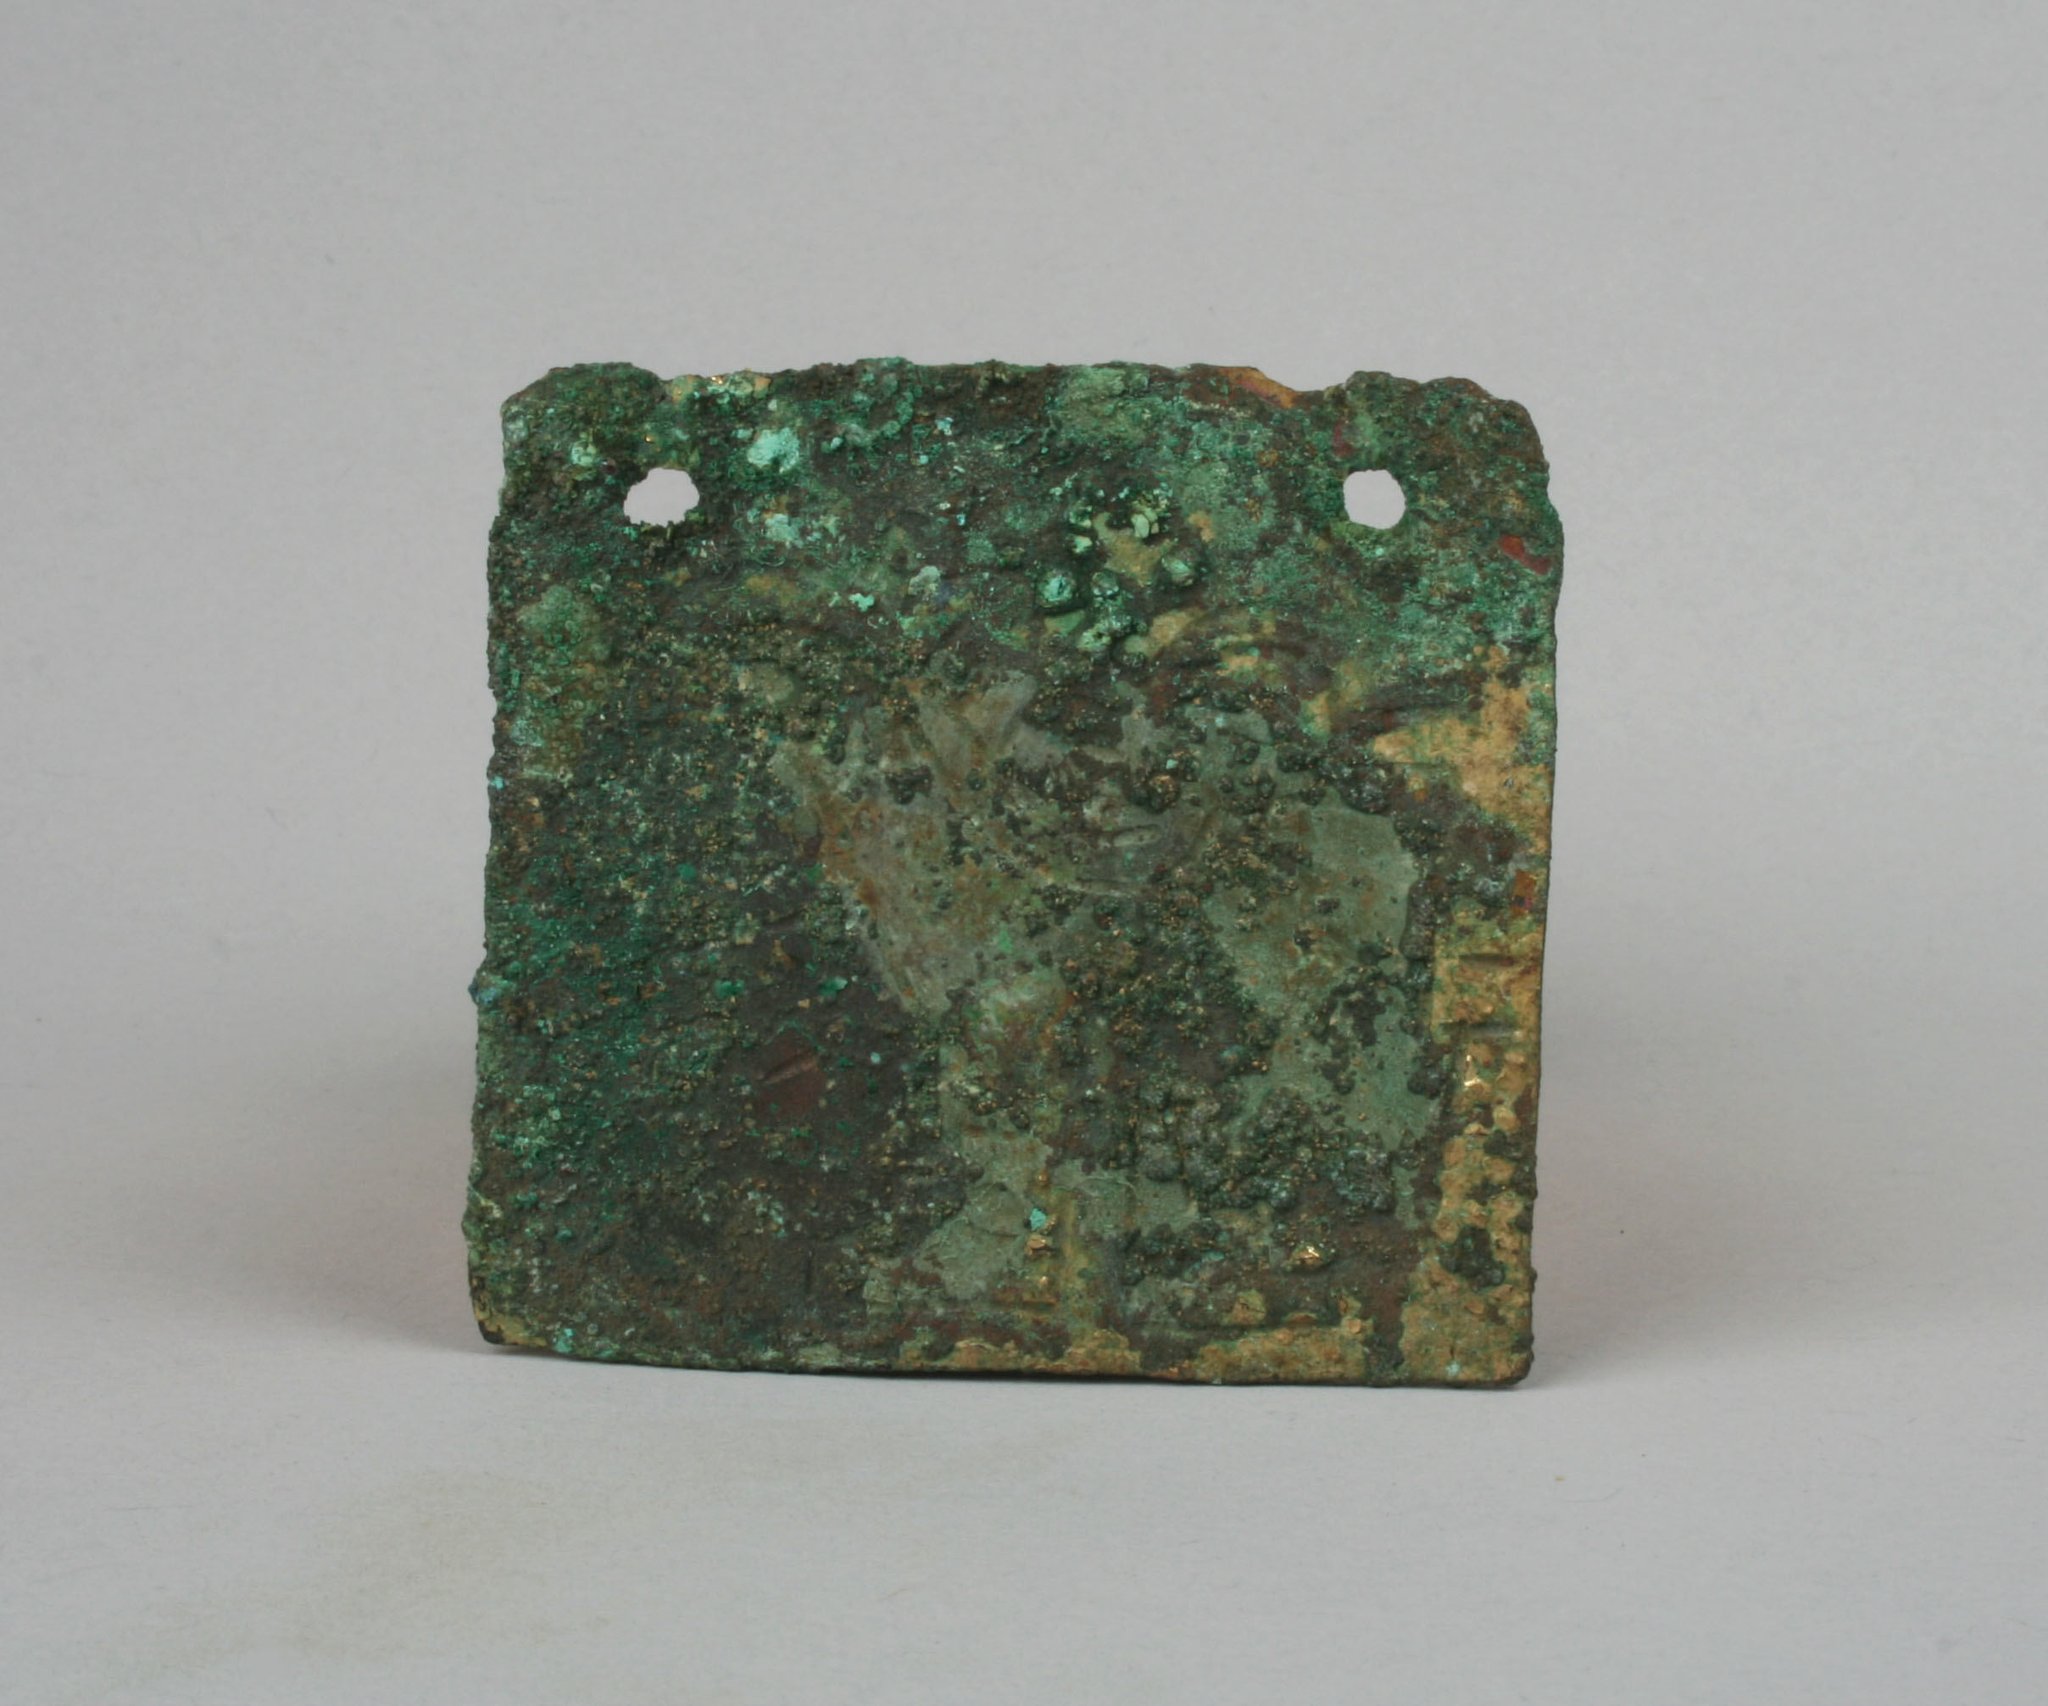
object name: ornament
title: Bird Plaque Ornament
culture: vicús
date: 300 BCE-200 CE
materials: copper, gilt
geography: peru